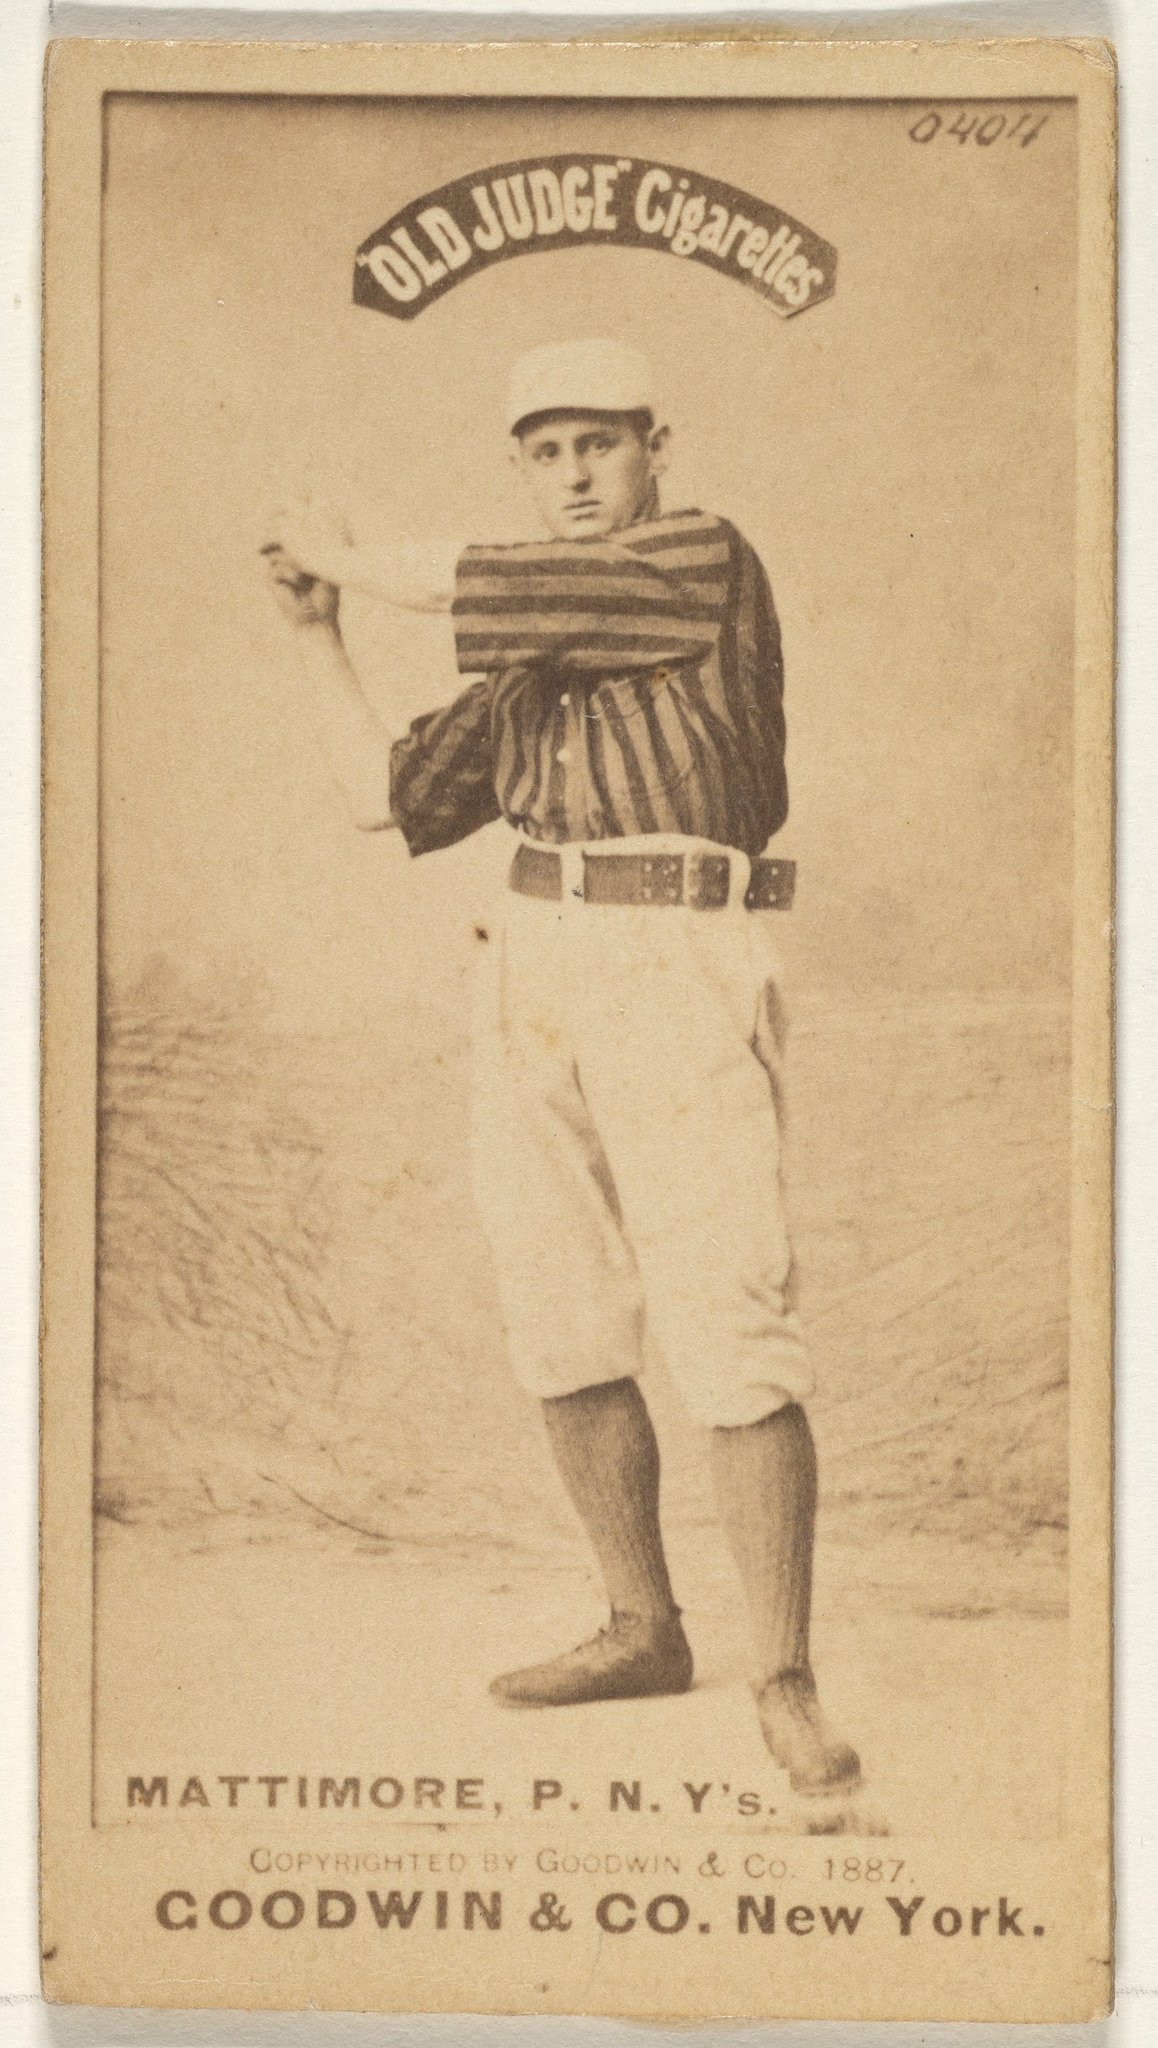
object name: baseball card, photograph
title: Michael "Mike" Joseph Mattimore, Pitcher, New York, from the Old Judge series (N172) for Old Judge Cigarettes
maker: goodwin & company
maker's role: publisher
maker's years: 1850-1950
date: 1887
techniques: albumen silver print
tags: men,portraits,baseball,athletes